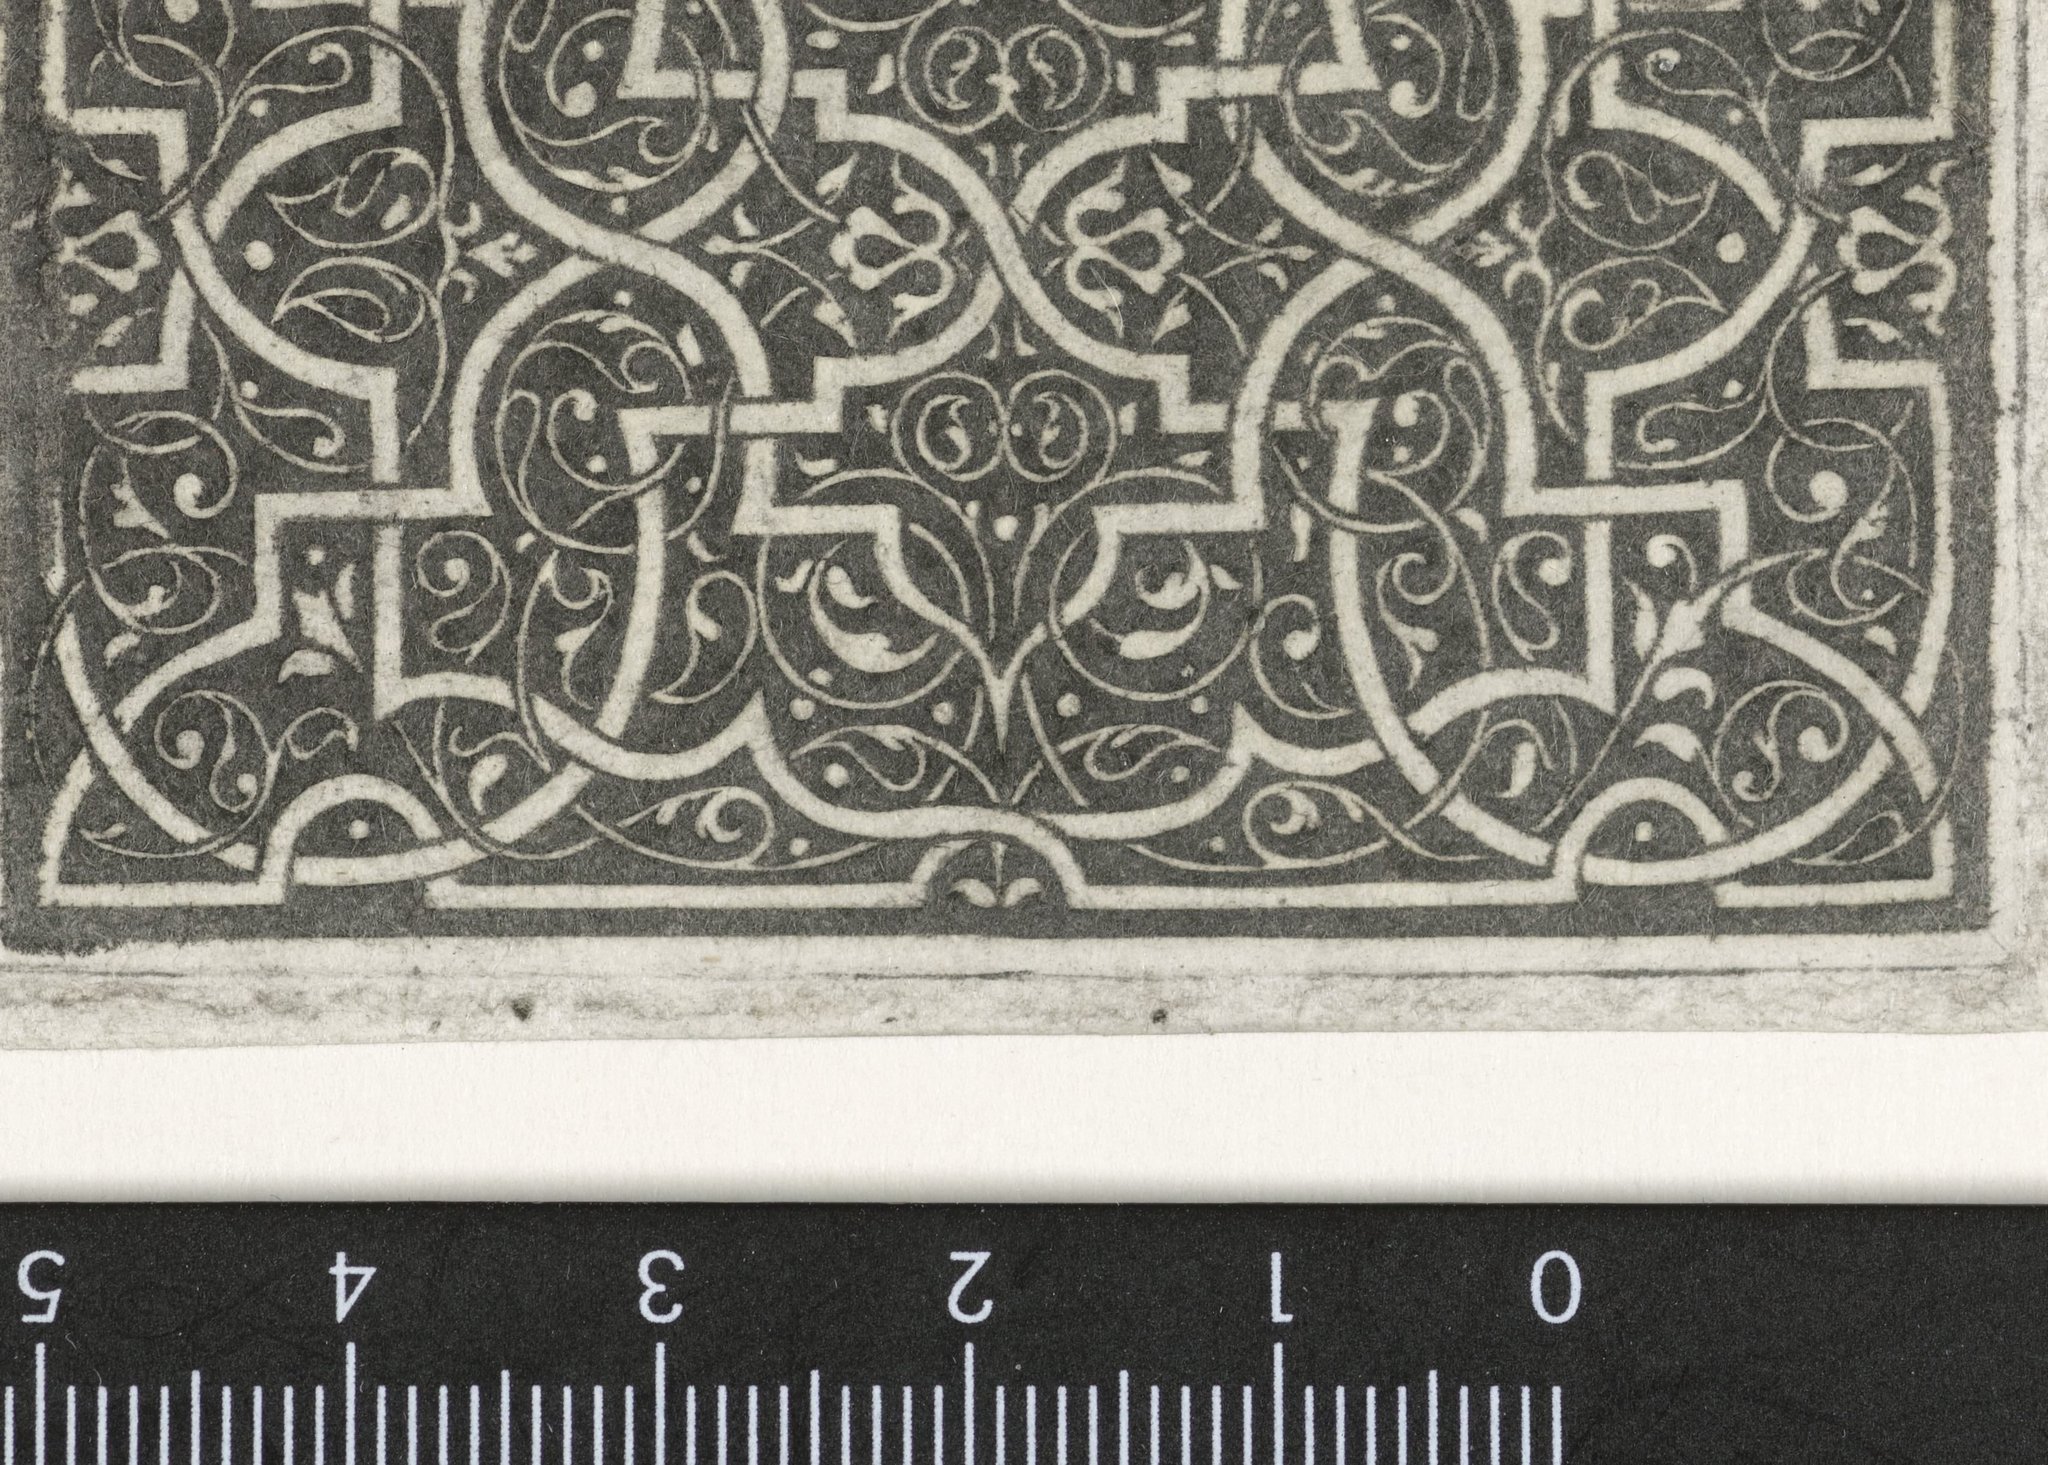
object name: print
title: Moresken en arabesken in een vier maal gespiegeld motief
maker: Anonymous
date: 1516-1571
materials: niello, paper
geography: france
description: In de vier hoeken bevindt zich een cirkel, waarvan circa éénderde deel van de omtrek ontbreekt.